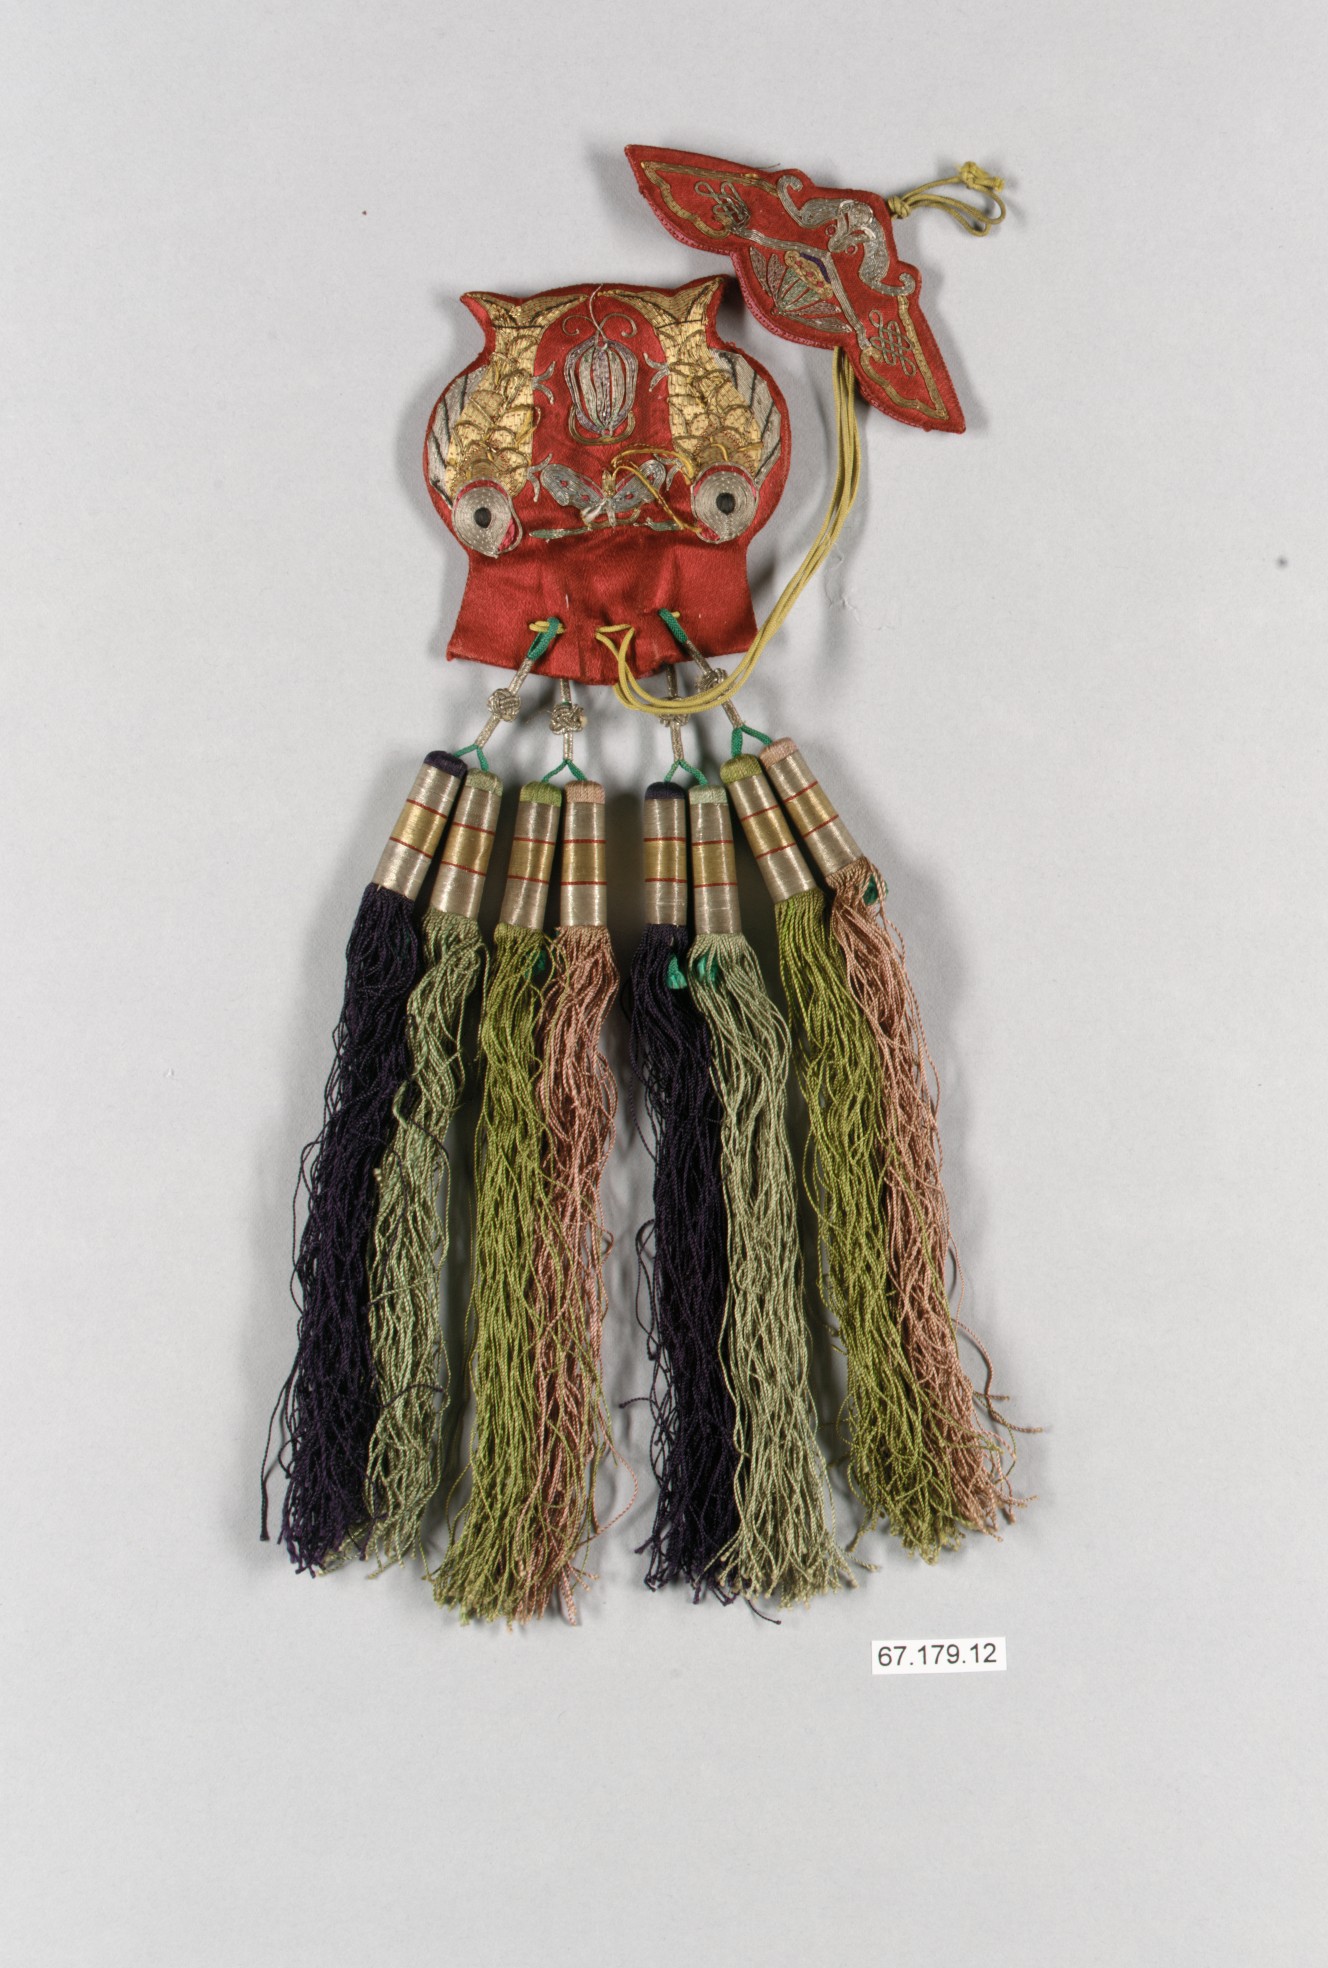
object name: purse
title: Purse with Cover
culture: chinese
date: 1801-1900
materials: metal thread, silk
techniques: embroidery